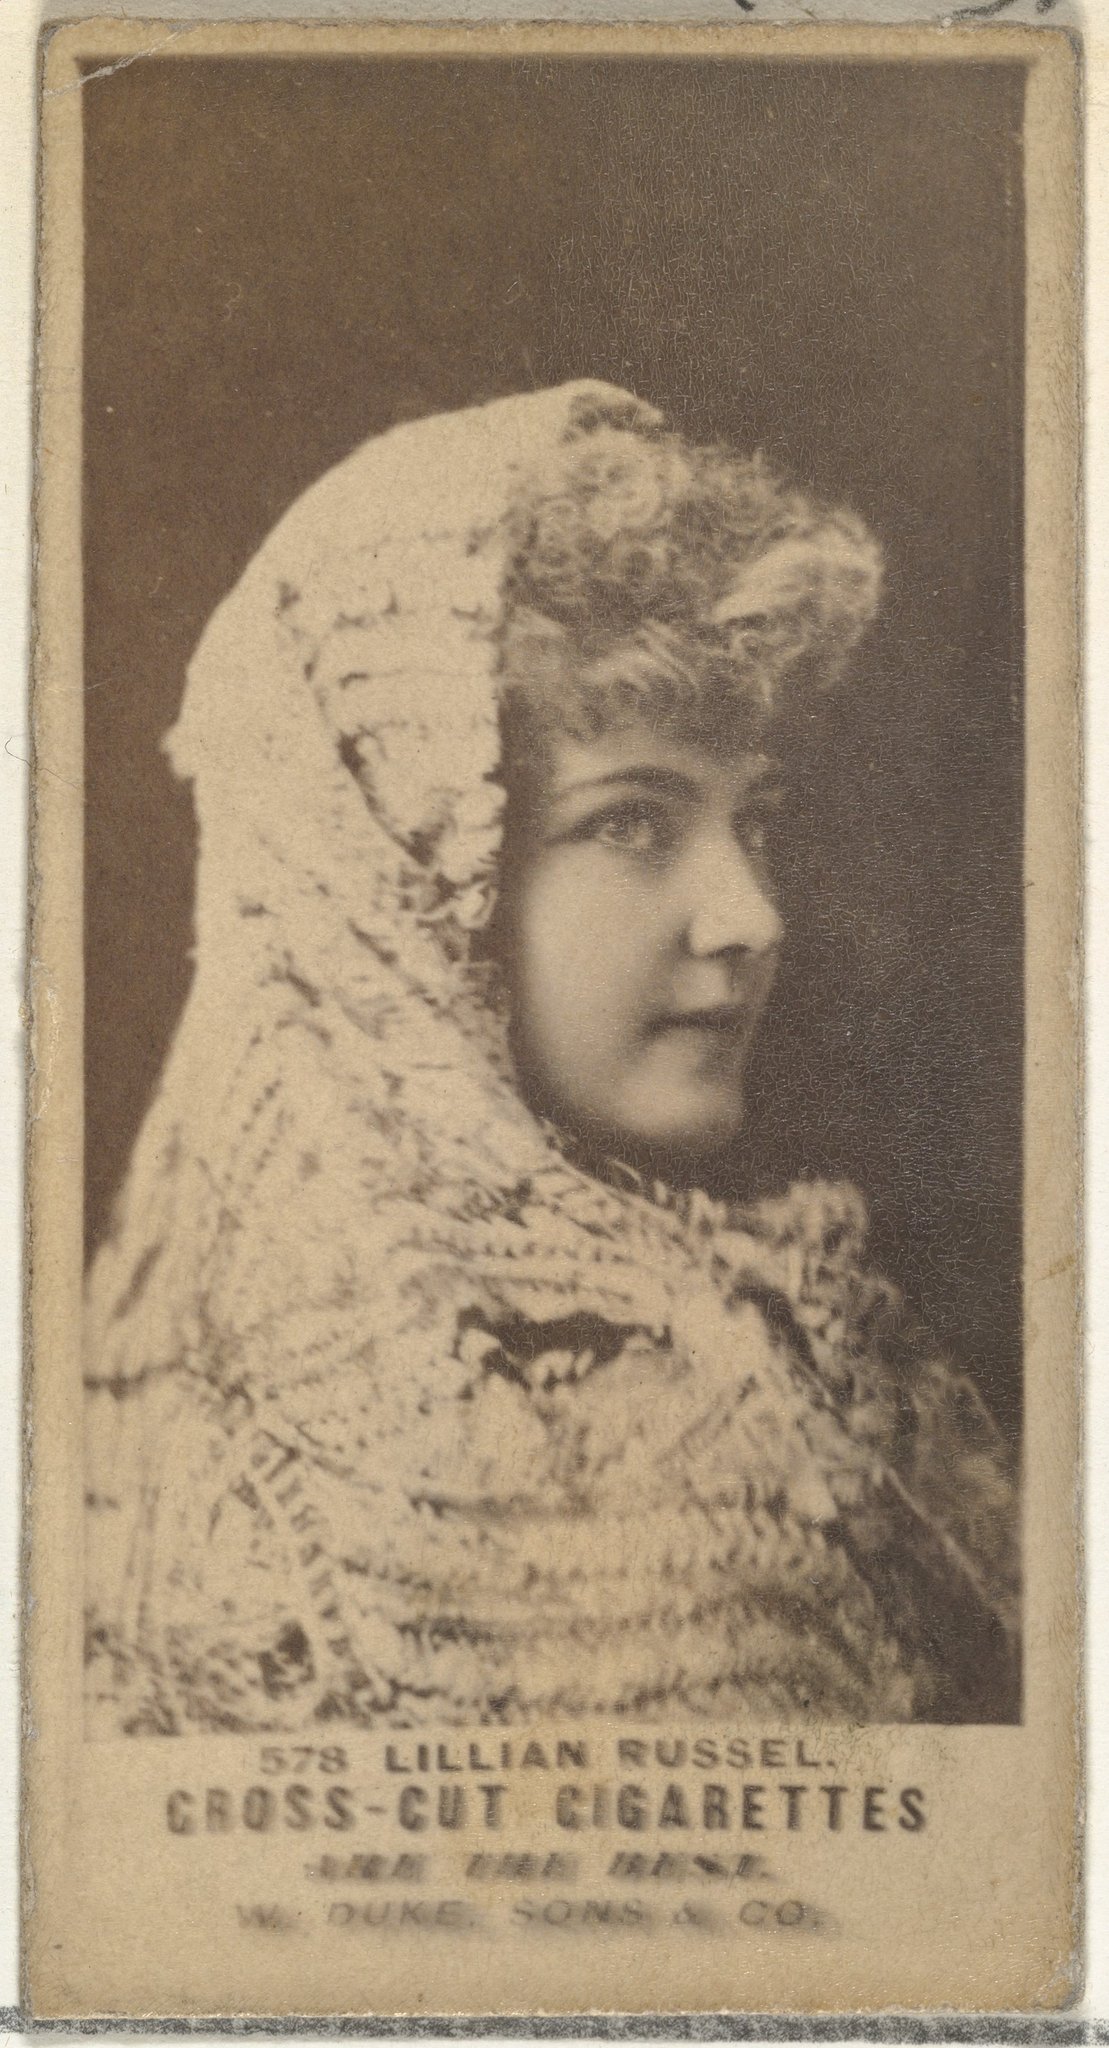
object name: photograph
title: Card Number 578, Lillian Russell, from the Actors and Actresses series (N145-3) issued by Duke Sons & Co. to promote Cross Cut Cigarettes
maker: w. duke, sons & co.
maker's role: publisher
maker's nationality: american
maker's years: 1870-1920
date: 1880-1889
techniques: albumen silver print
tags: portraits,women,actresses